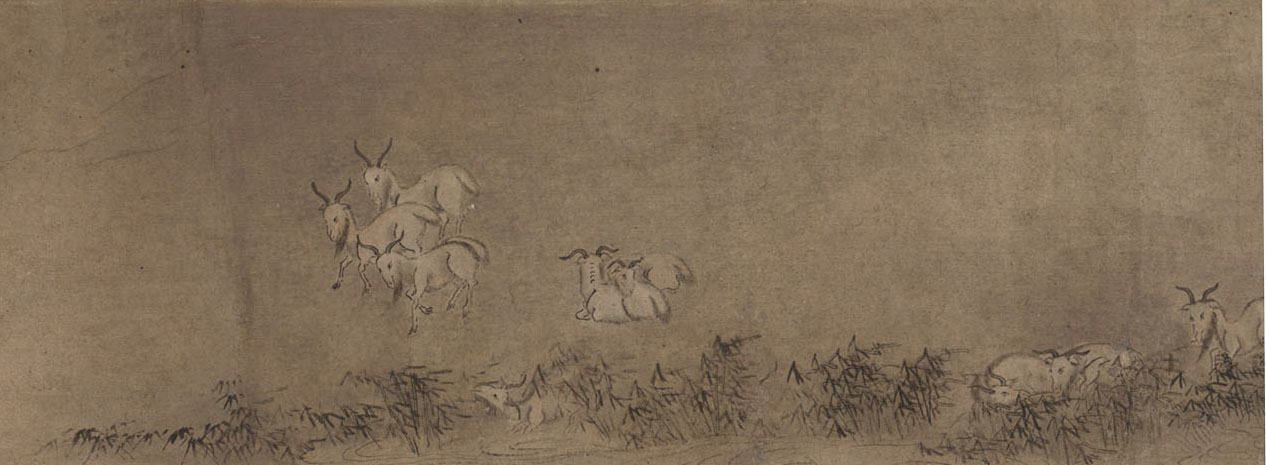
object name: handscroll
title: Bullocks and Goats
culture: chinese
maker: unidentified artist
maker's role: artist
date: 1644-1911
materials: ink, paper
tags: bulls,goats